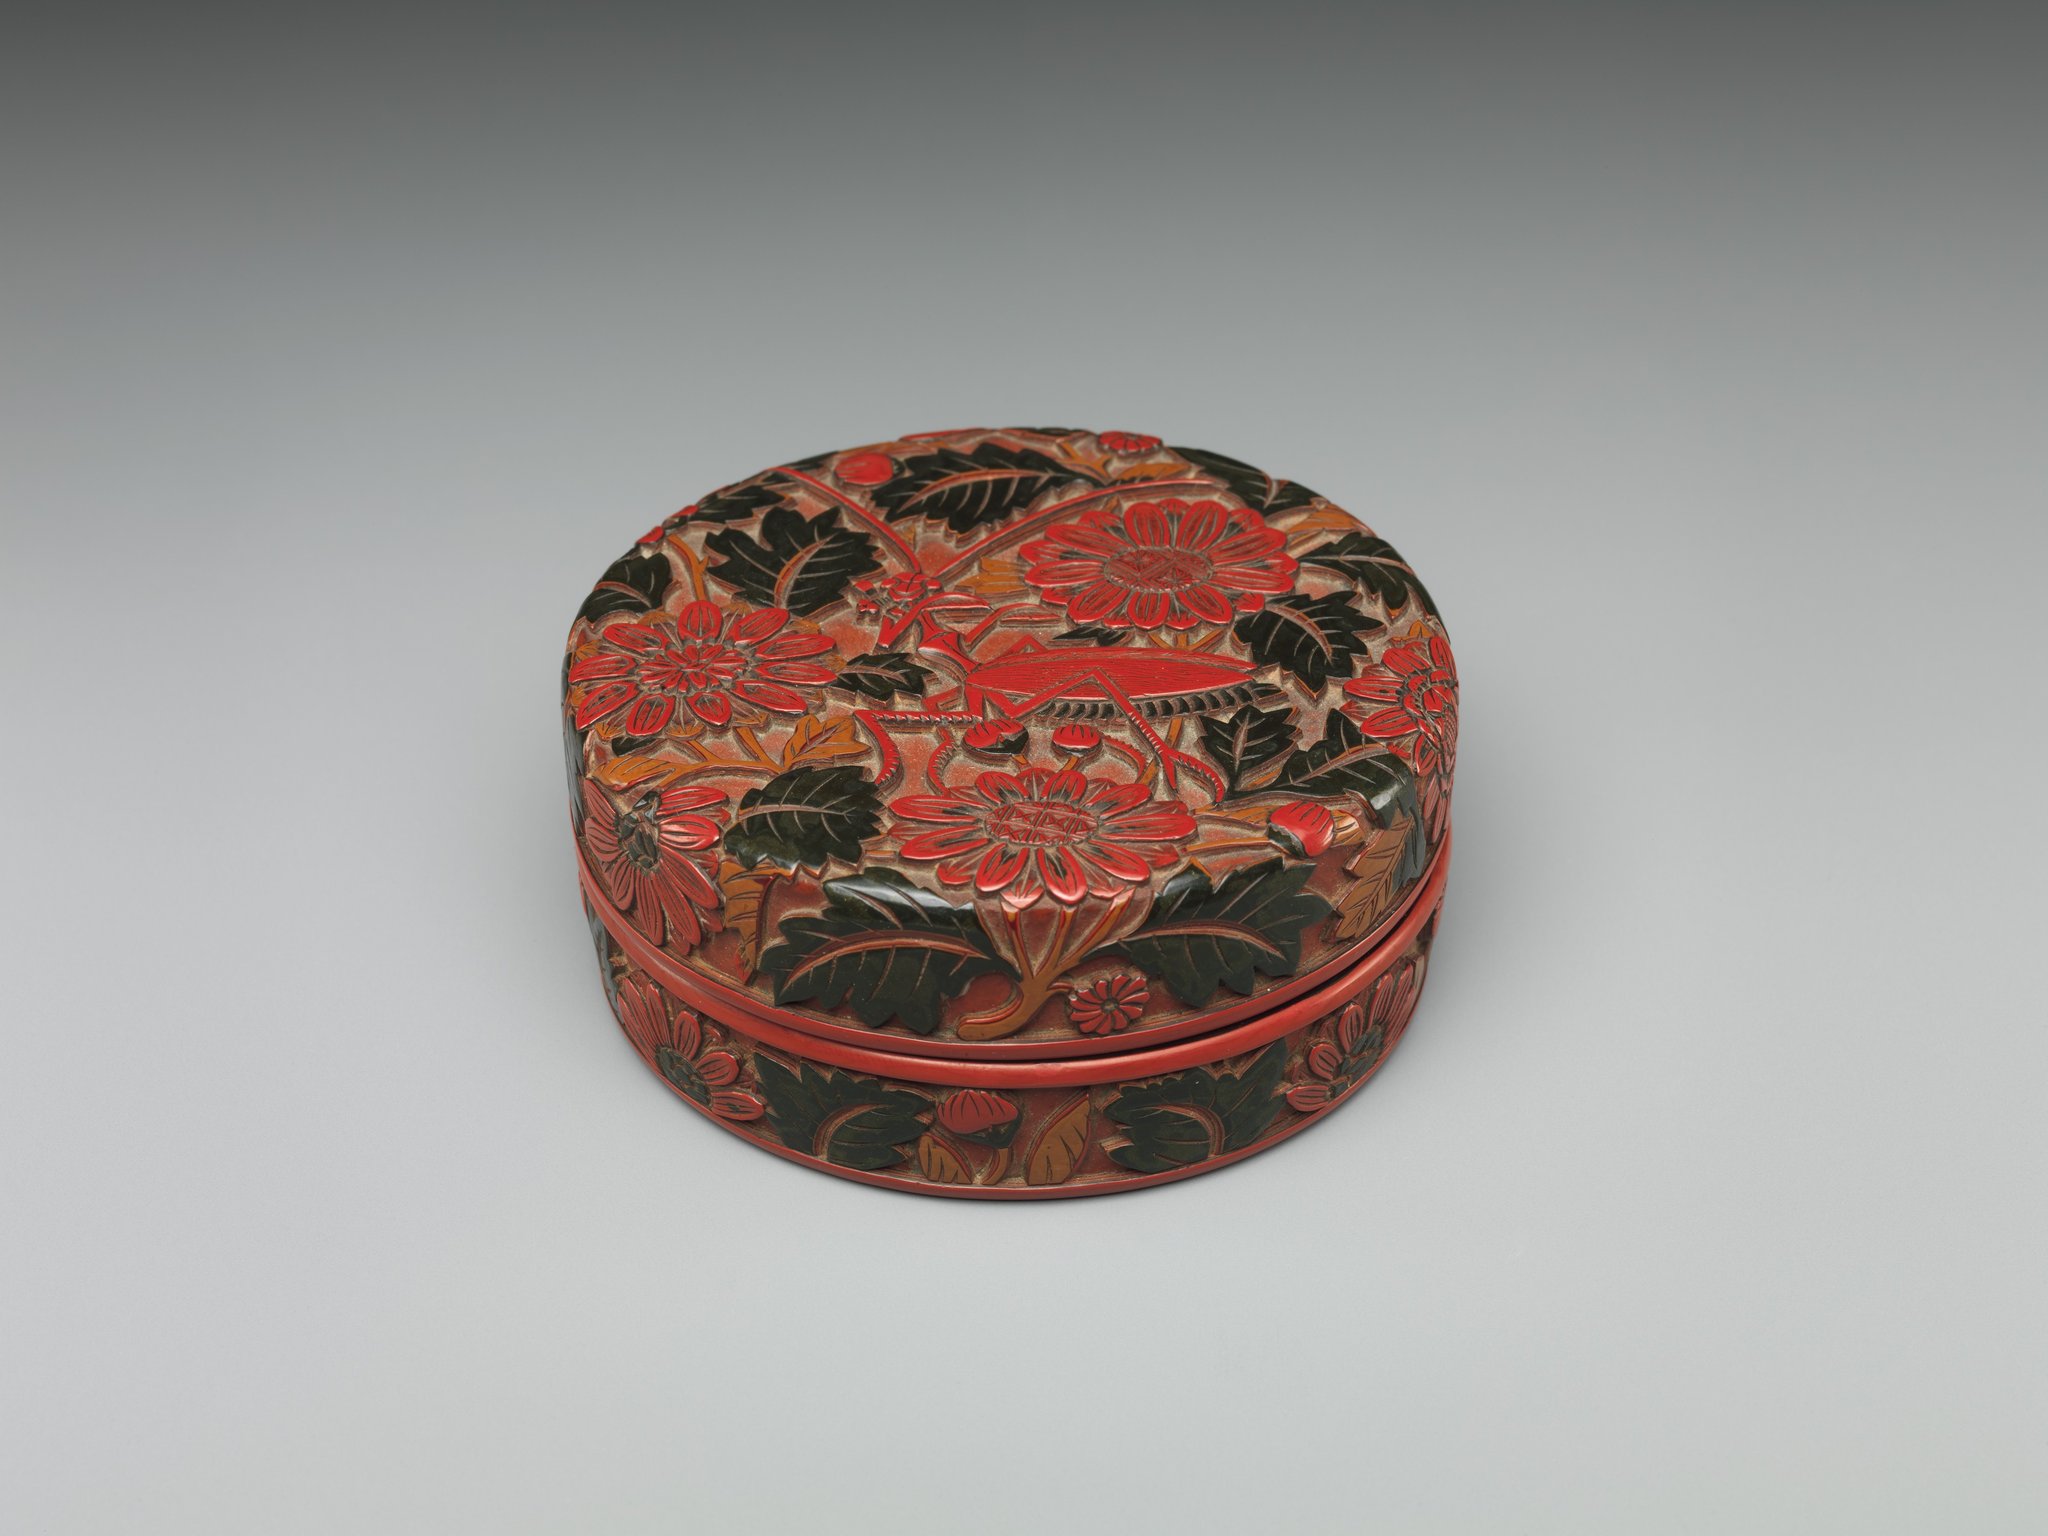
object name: box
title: Box with chrysanthemum and praying mantis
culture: chinese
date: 1501-1600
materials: lacquer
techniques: carving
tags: insects,flowers,leaves